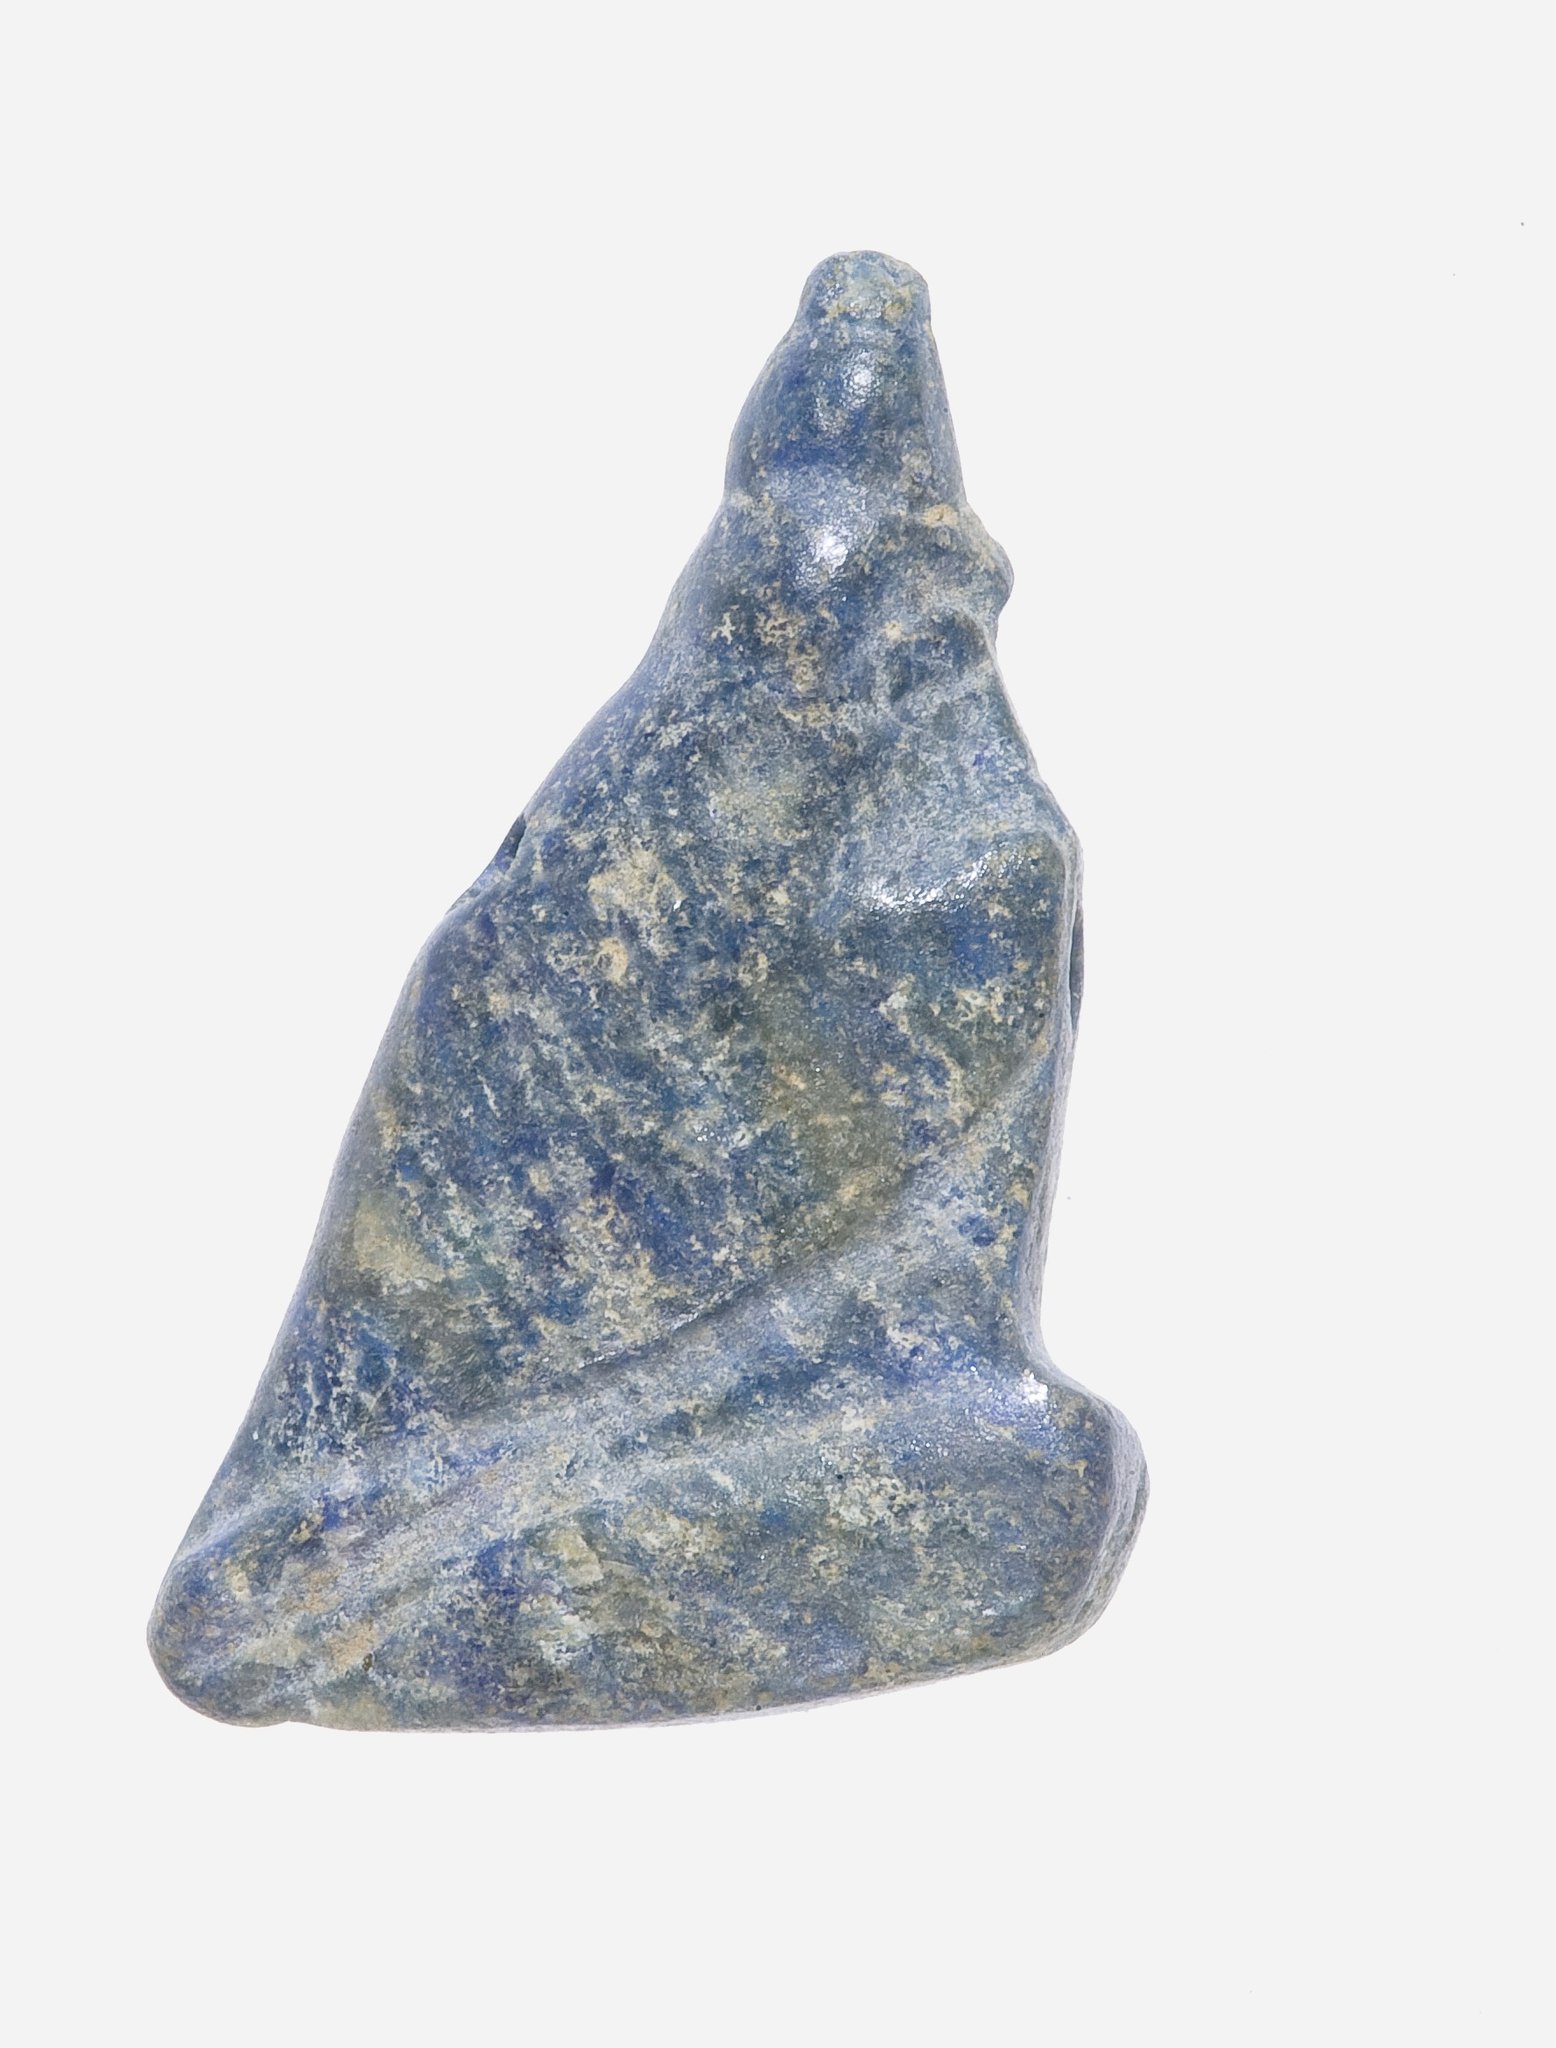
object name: amulet, falcon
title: Falcon amulet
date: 1950-1850 BCE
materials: lapis lazuli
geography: egypt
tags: falcons